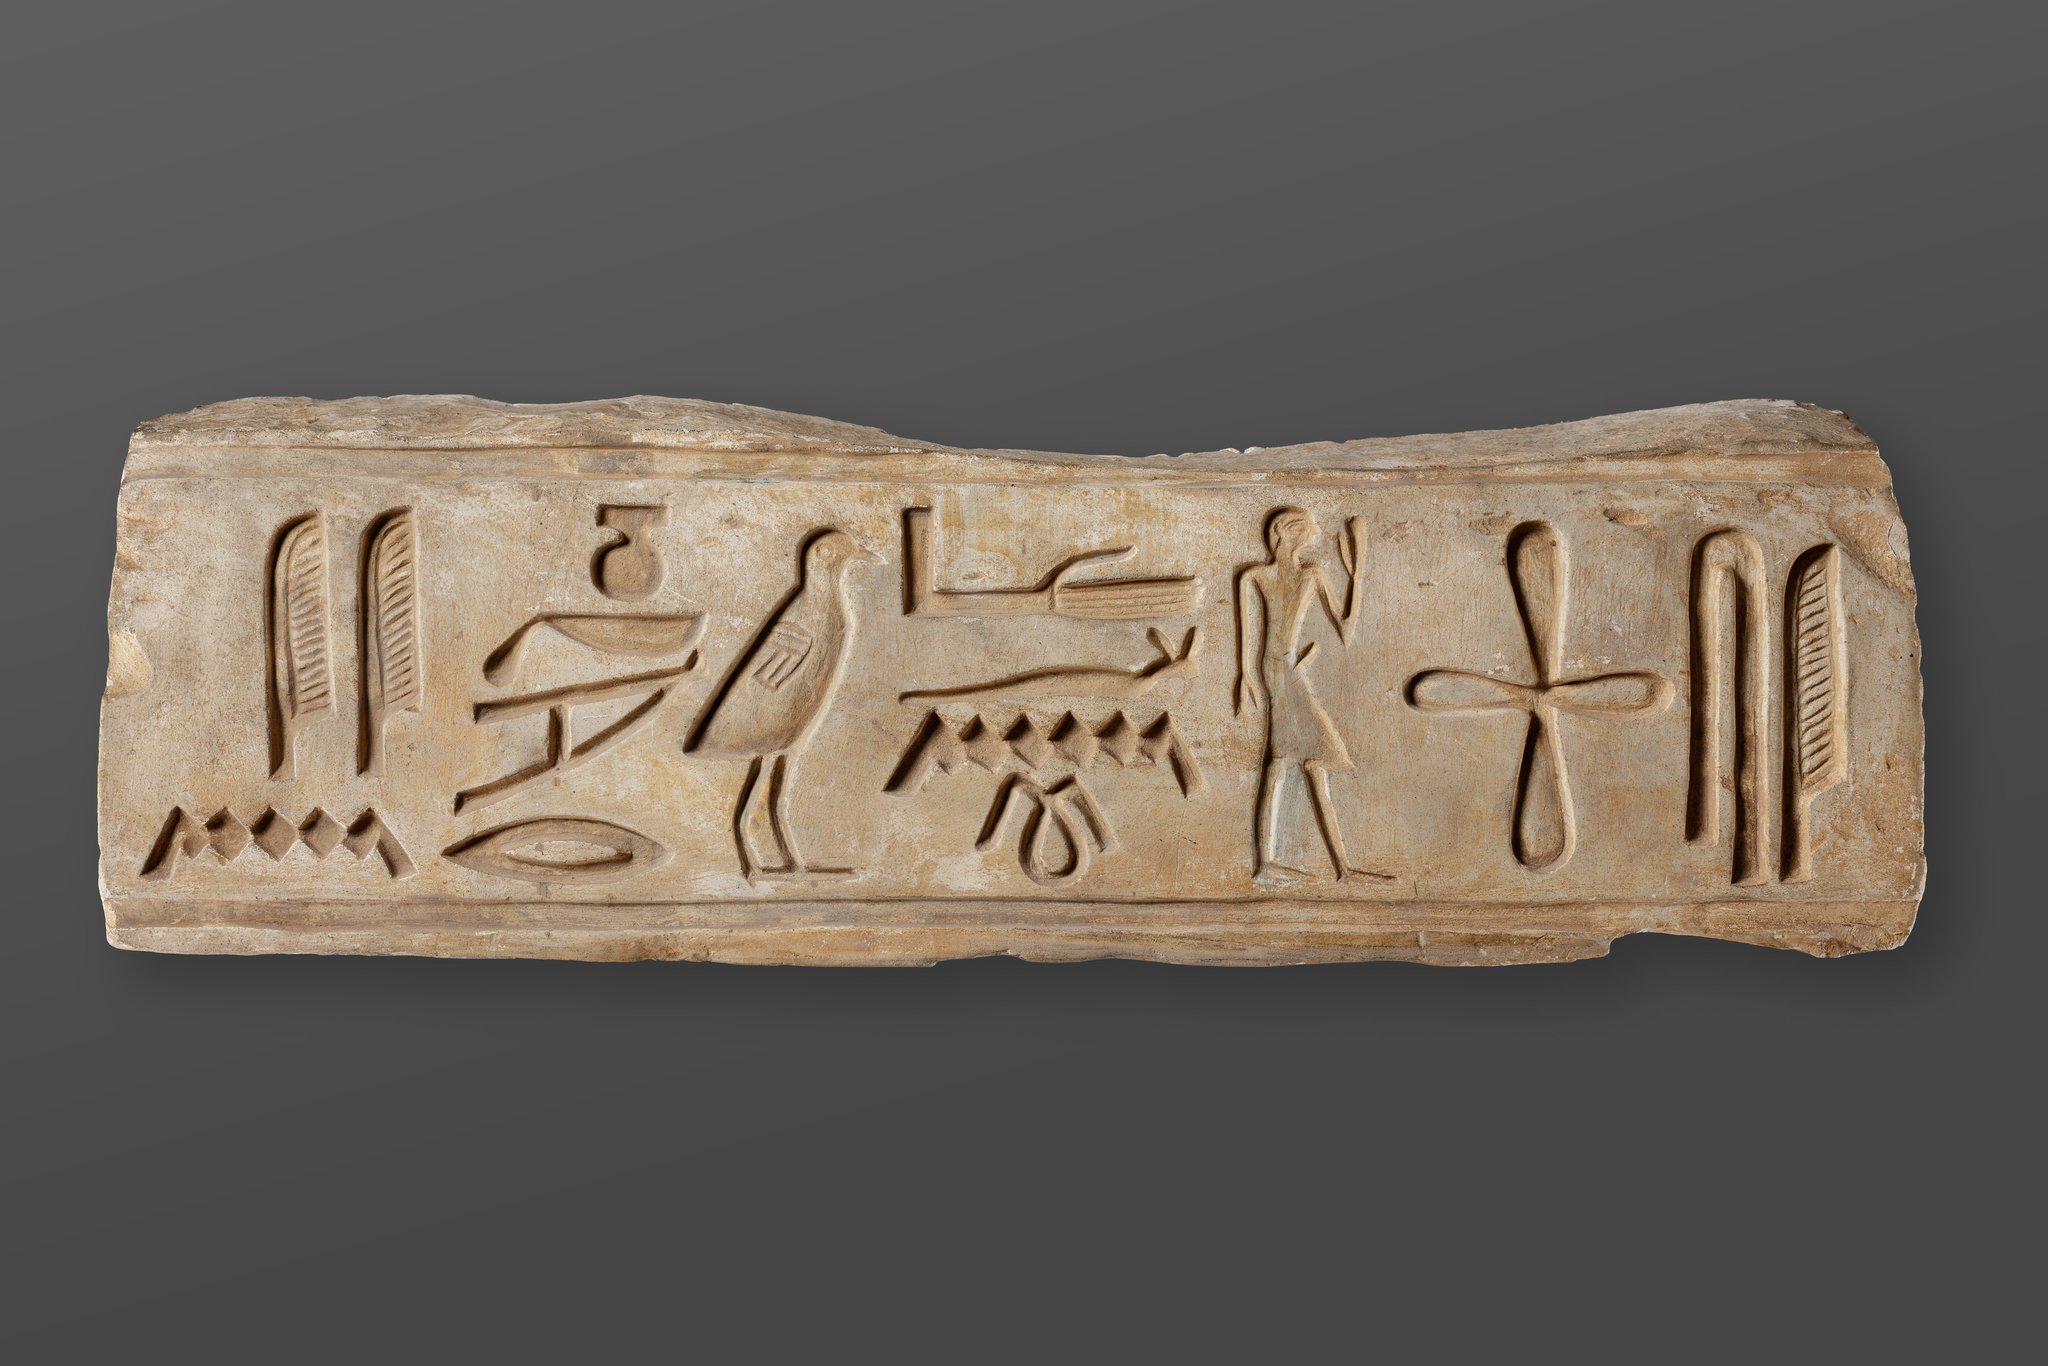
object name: relief fragment, tomb of mereri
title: Frieze from the tomb of Mereri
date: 2100-2030 BCE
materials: limestone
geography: egypt